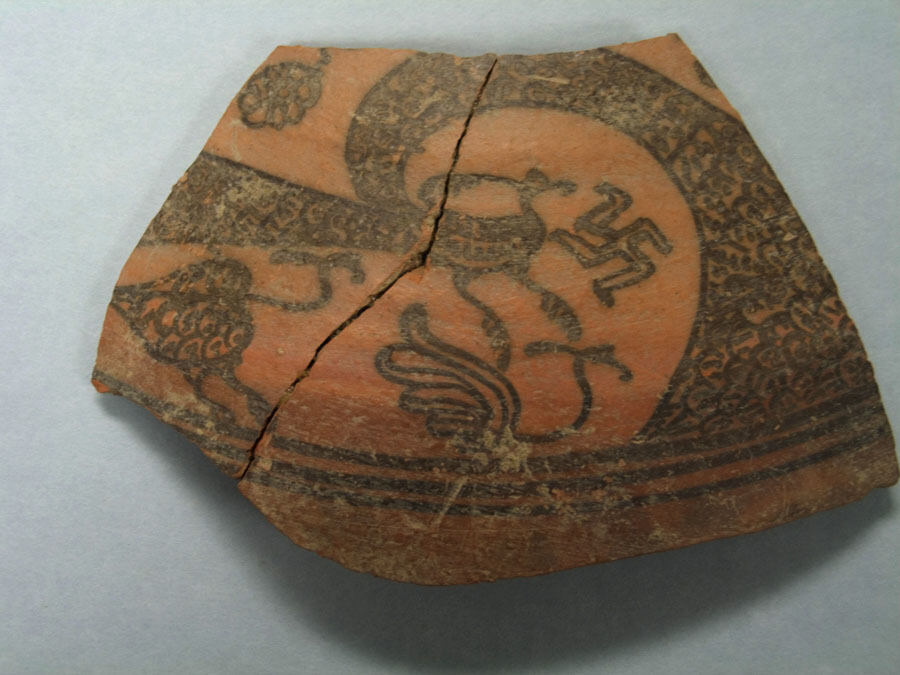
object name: shard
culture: pakistani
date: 301-500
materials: terracotta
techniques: painting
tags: gandhara,peacocks